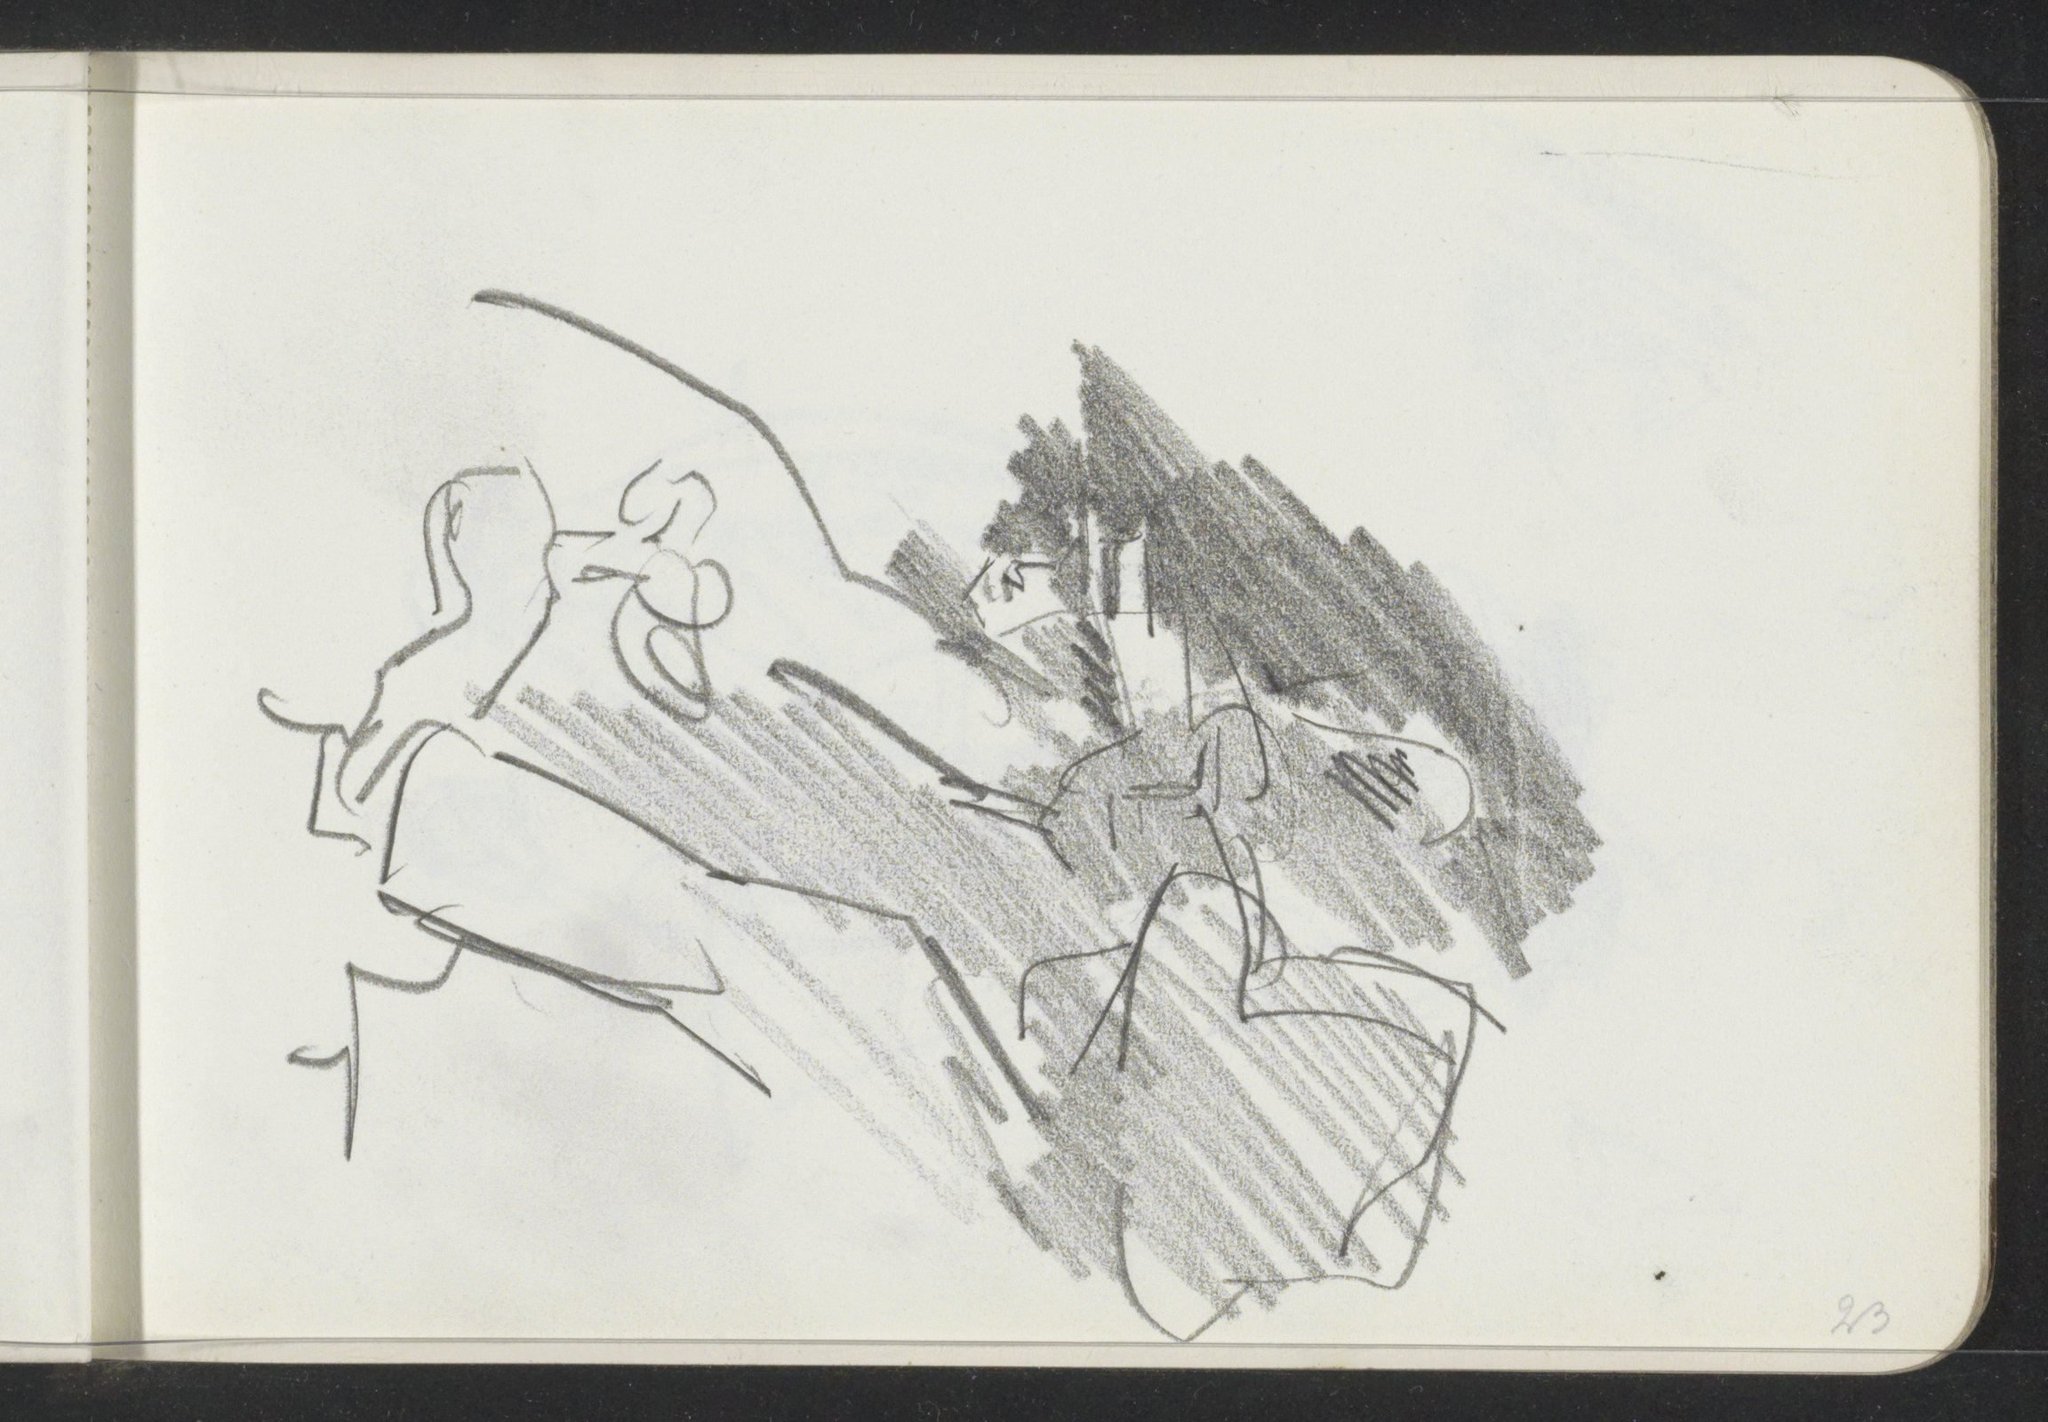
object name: sketchbook leaf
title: Figuren op een terras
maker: isaac israels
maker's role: draughtsman, painter, print maker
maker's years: 1865-1934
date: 1875-1934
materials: paper, pencil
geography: the hague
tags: adult man (+ sitting), pavement, terrace in front of inn or restaurant, adult woman (+ sitting)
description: Blad 23 recto uit schetsboek LX met 33 bladen.